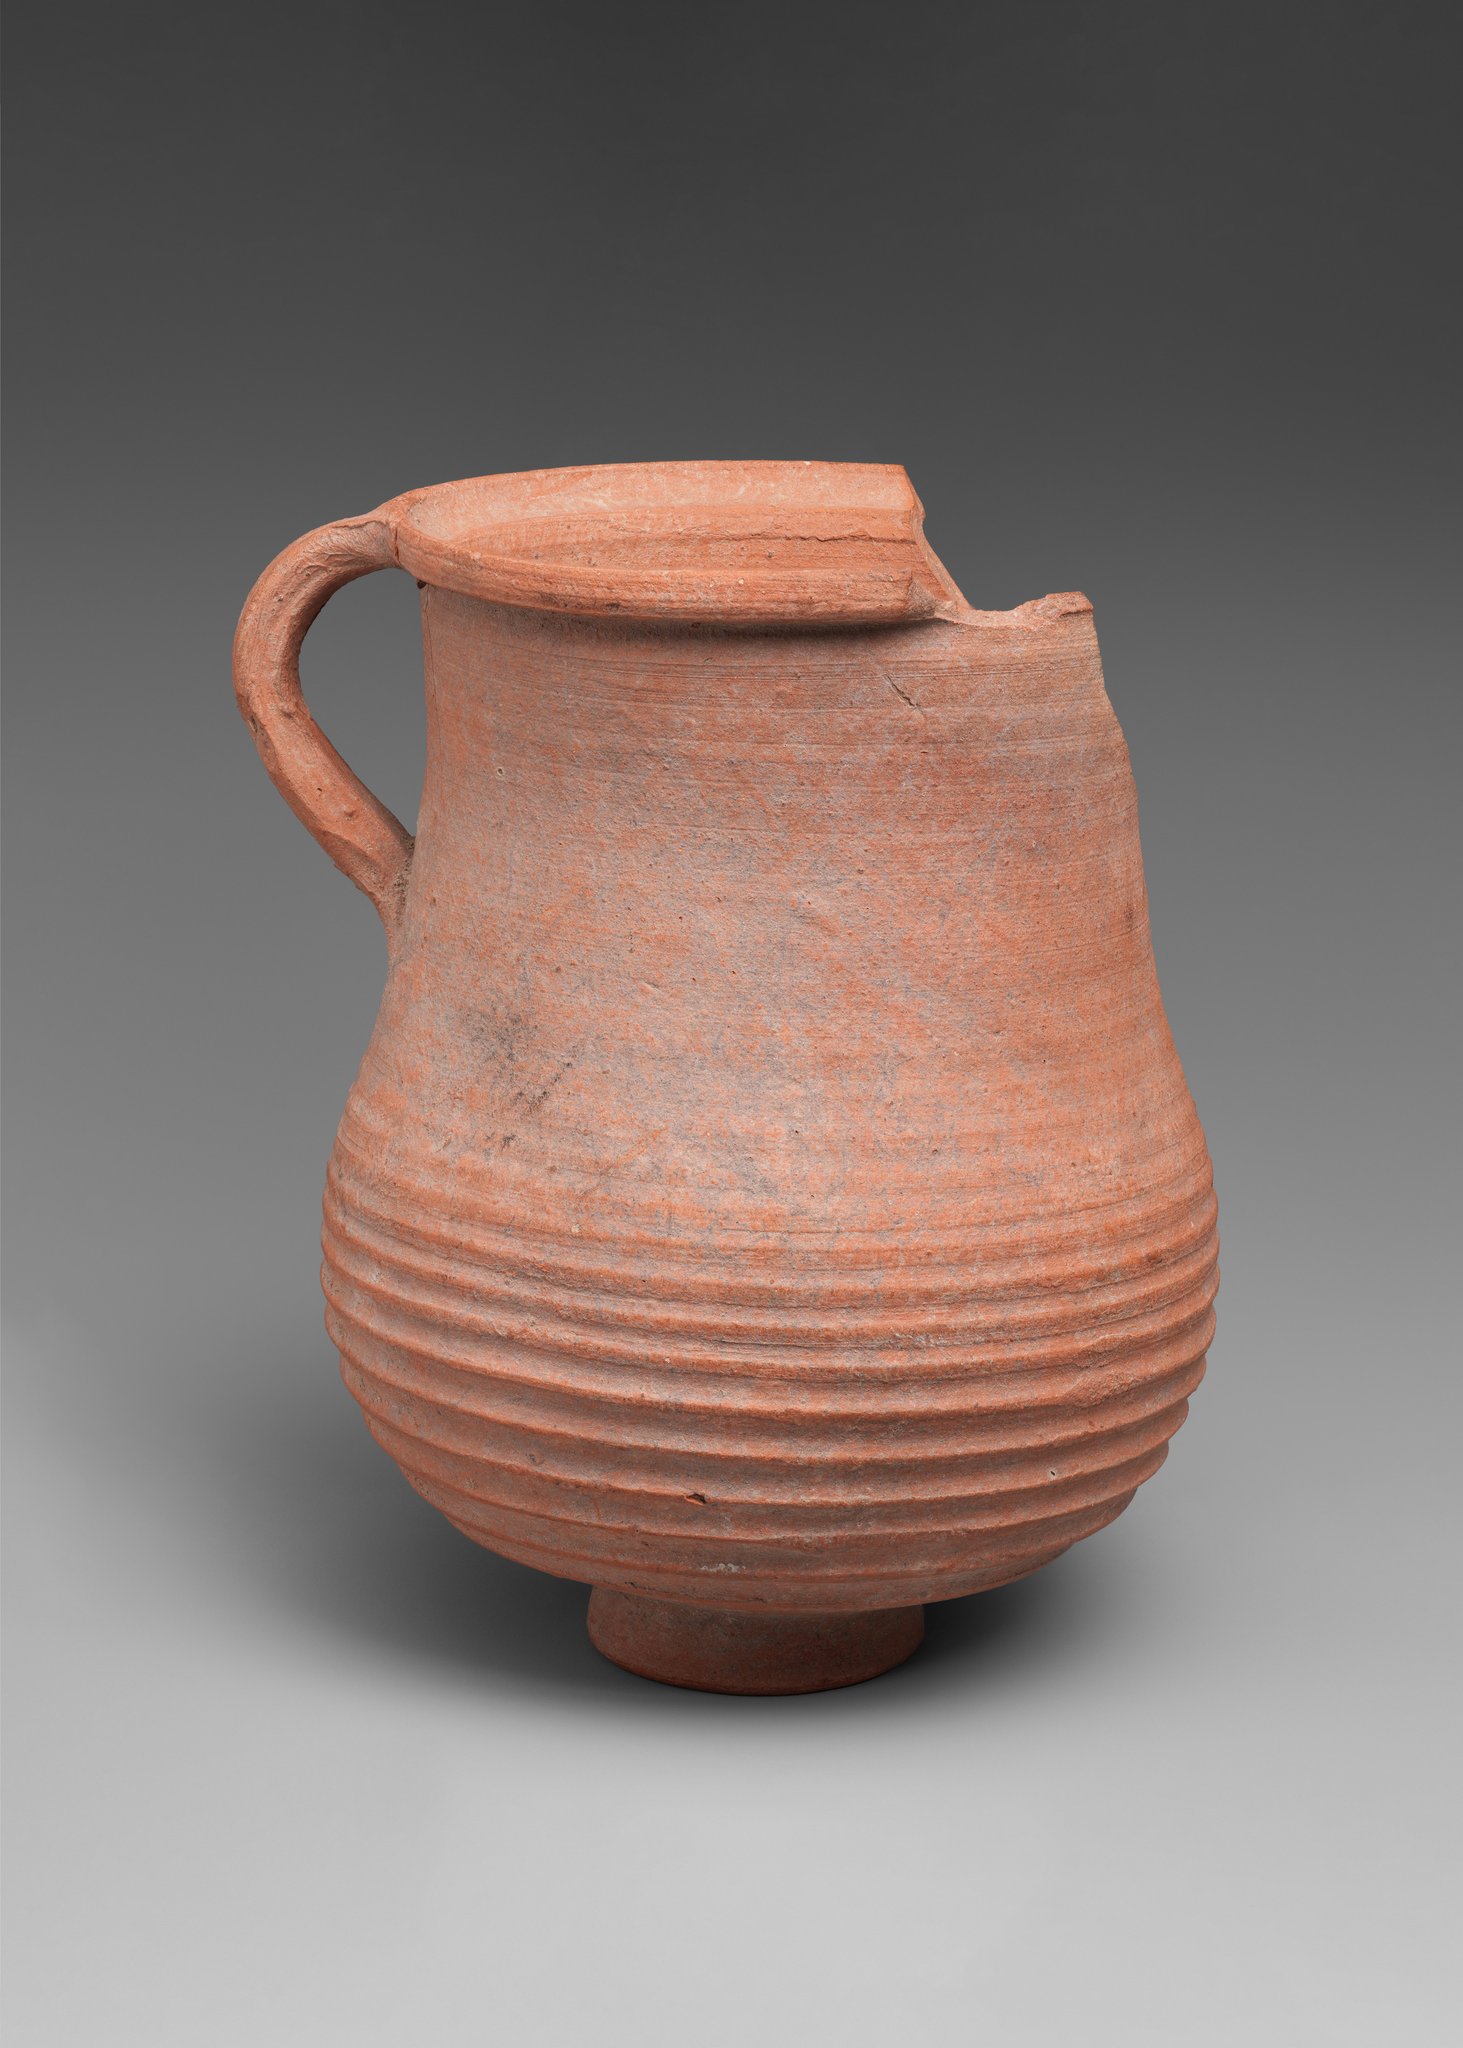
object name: juglet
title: Ribbed juglet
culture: nabataean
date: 1-100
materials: ceramic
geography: levant